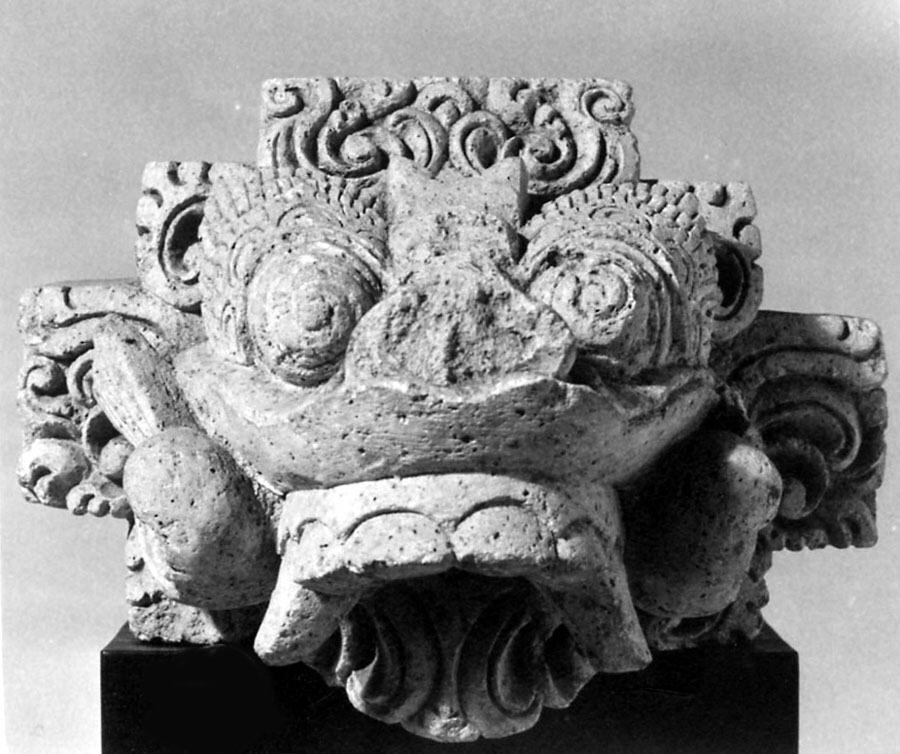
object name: fragment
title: Fragment of a Dragon Head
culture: indonesian, javanese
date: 701-900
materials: stone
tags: dragons